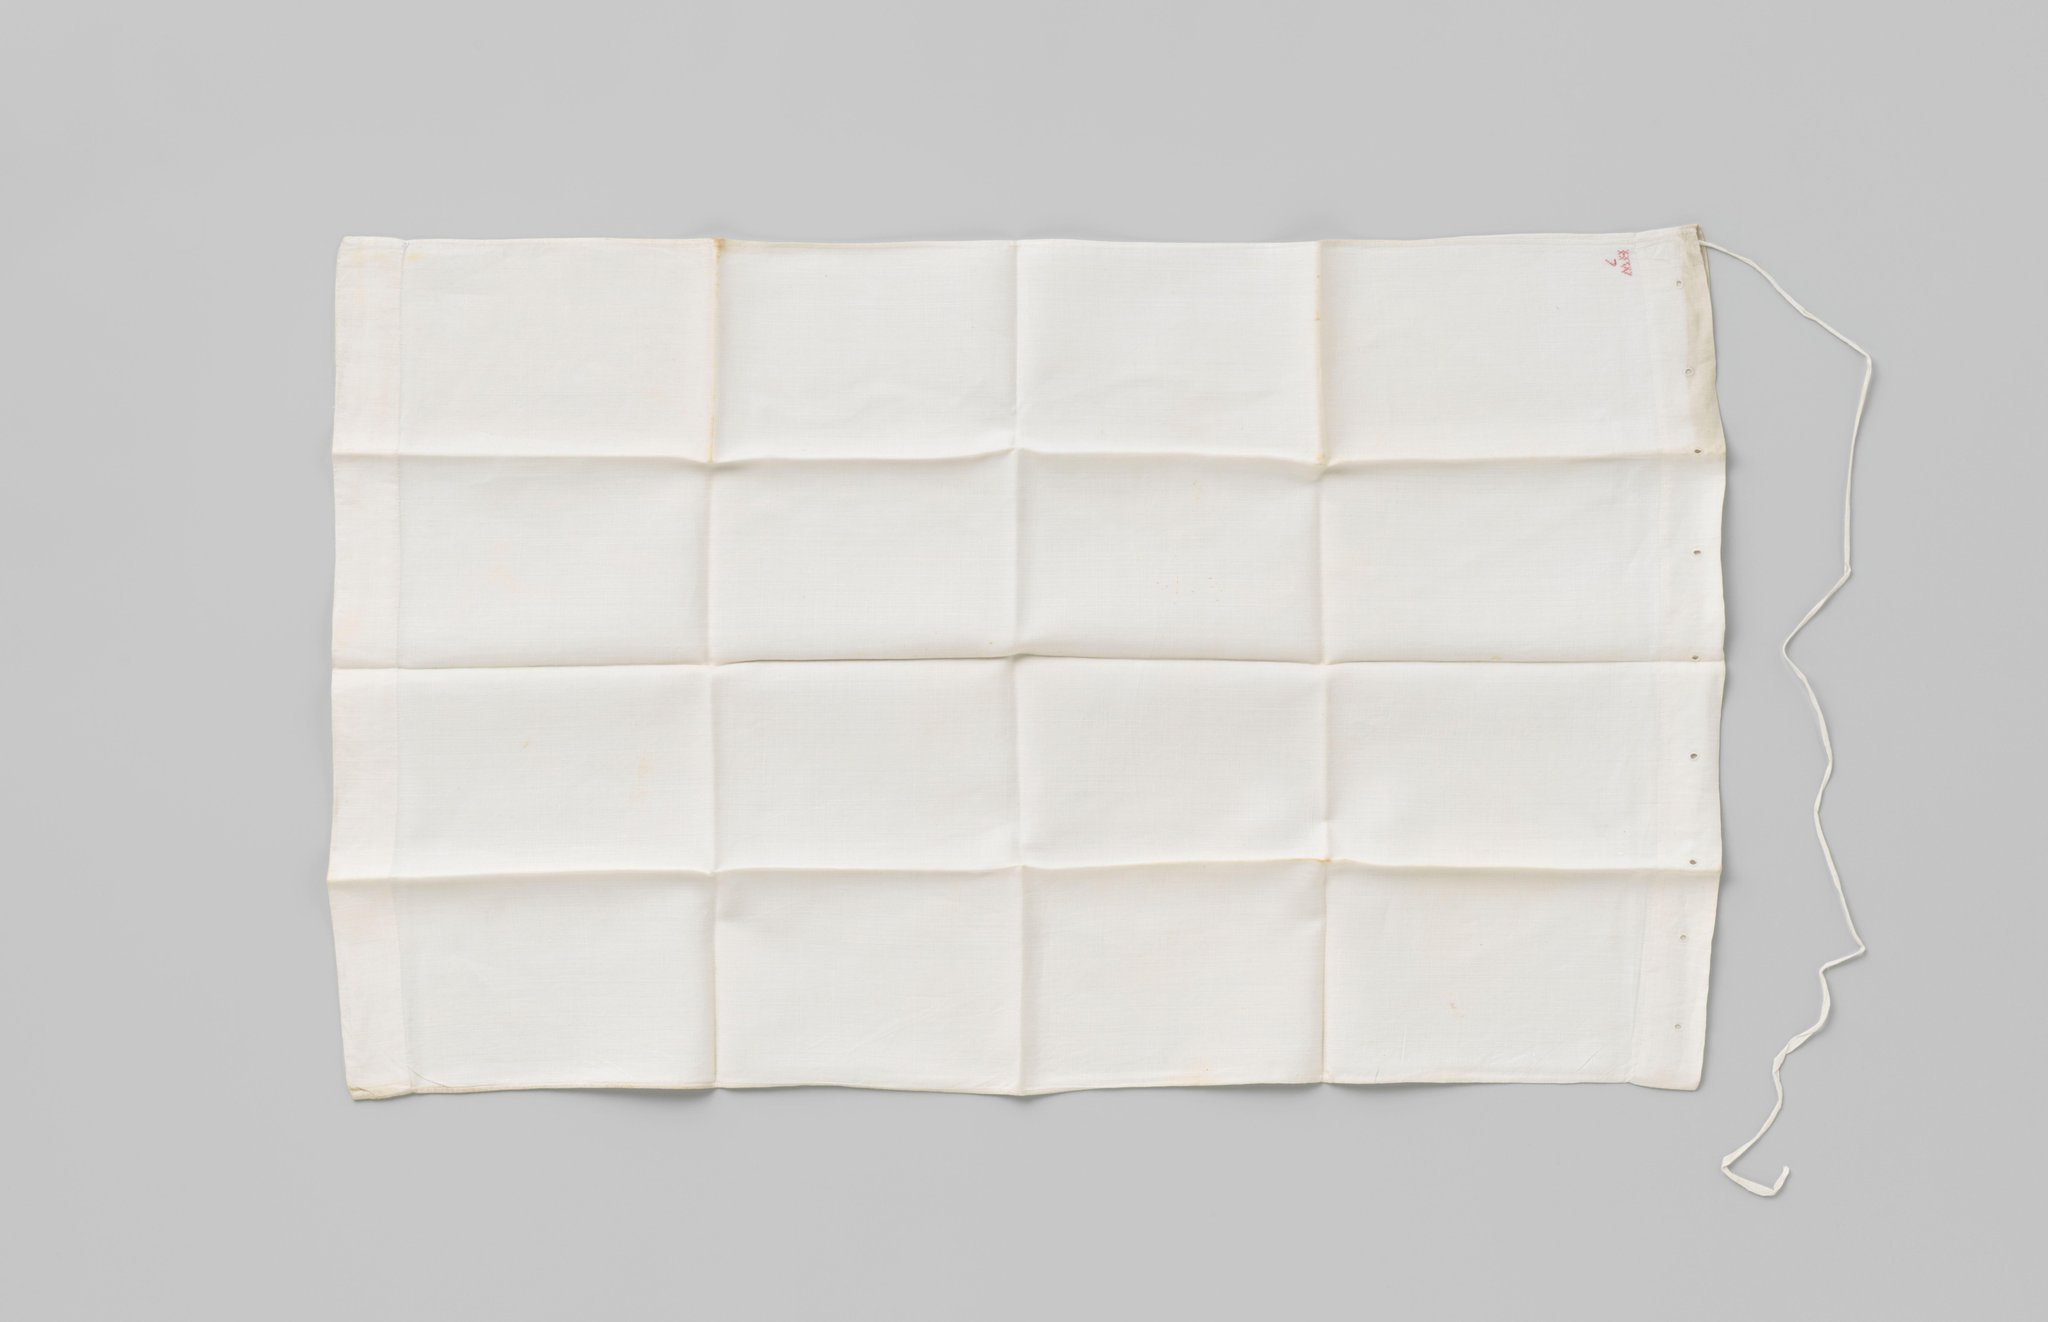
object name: lendensloop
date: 1820-1870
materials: linen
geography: northern netherlands